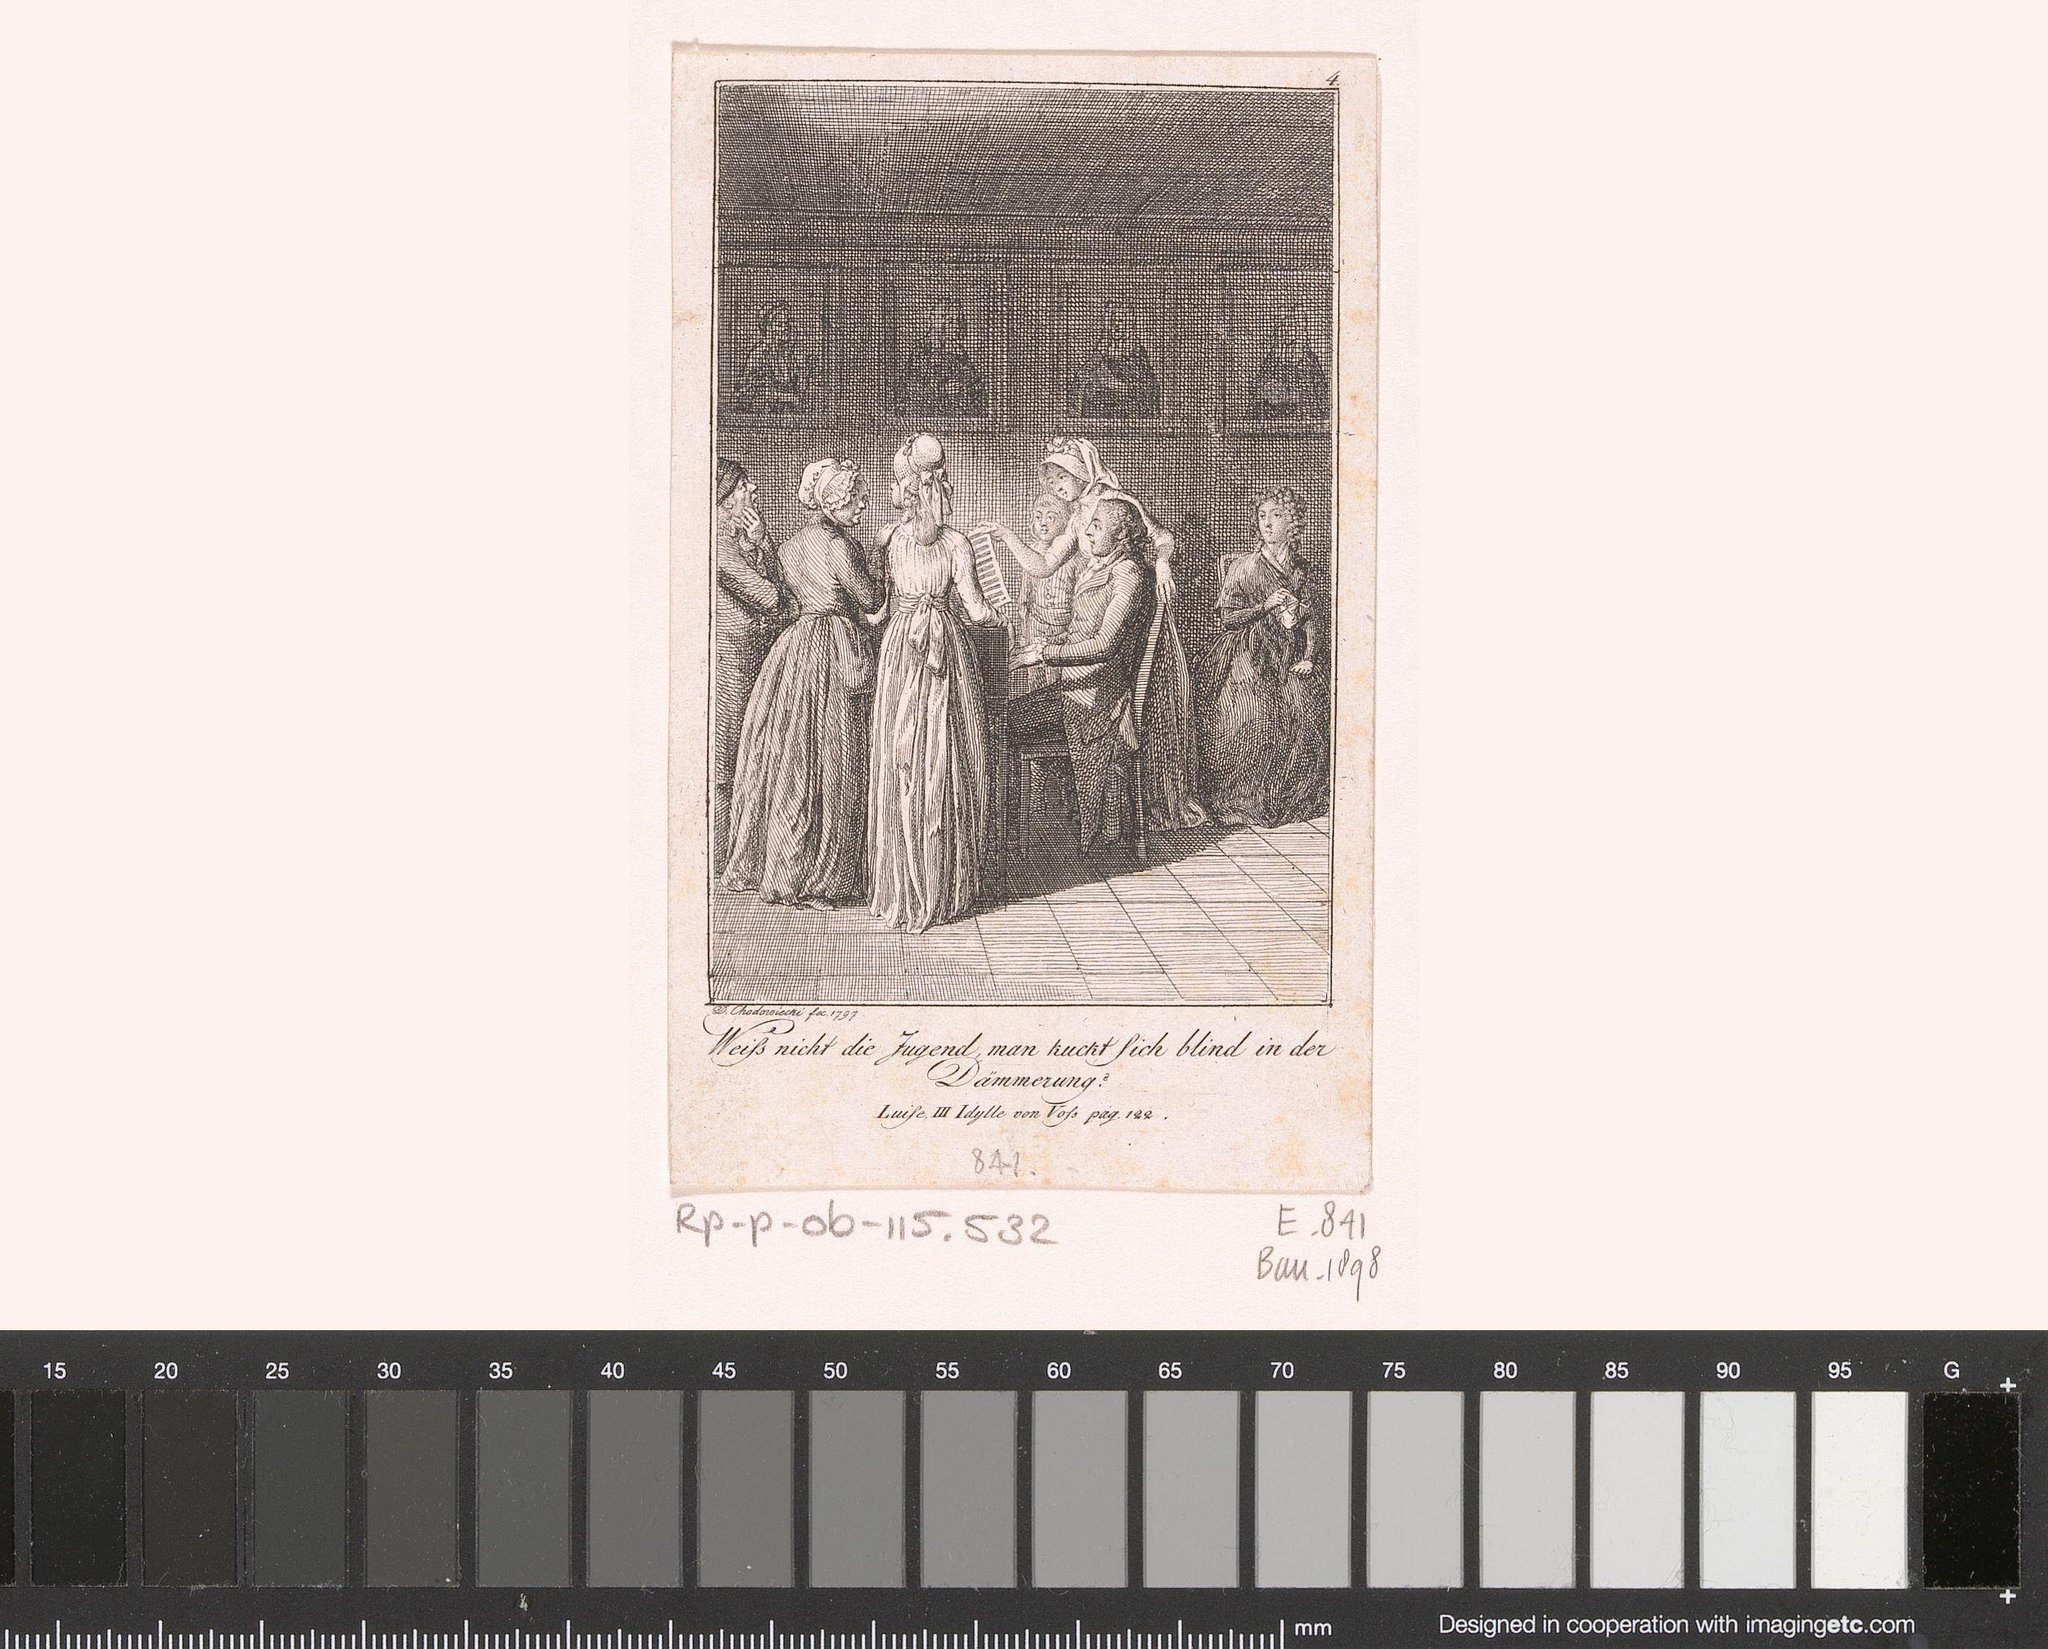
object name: print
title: Luise slaat de bladmuziek om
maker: daniel nikolaus chodowiecki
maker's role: draughtsman, print maker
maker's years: 1726-1801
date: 1797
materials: paper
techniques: etching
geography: berlin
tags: literature, vocal music, singing, clavichord, harpsichord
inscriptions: collector's mark: Lugt 2228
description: Prent gebruikt voor: Becker, Wilhelm Gottlieb. Almanach und Taschenbuch zum geselligen Vergnügen von W. G. Becker für 1798. Leipzig: Voss und Comp., [1797].